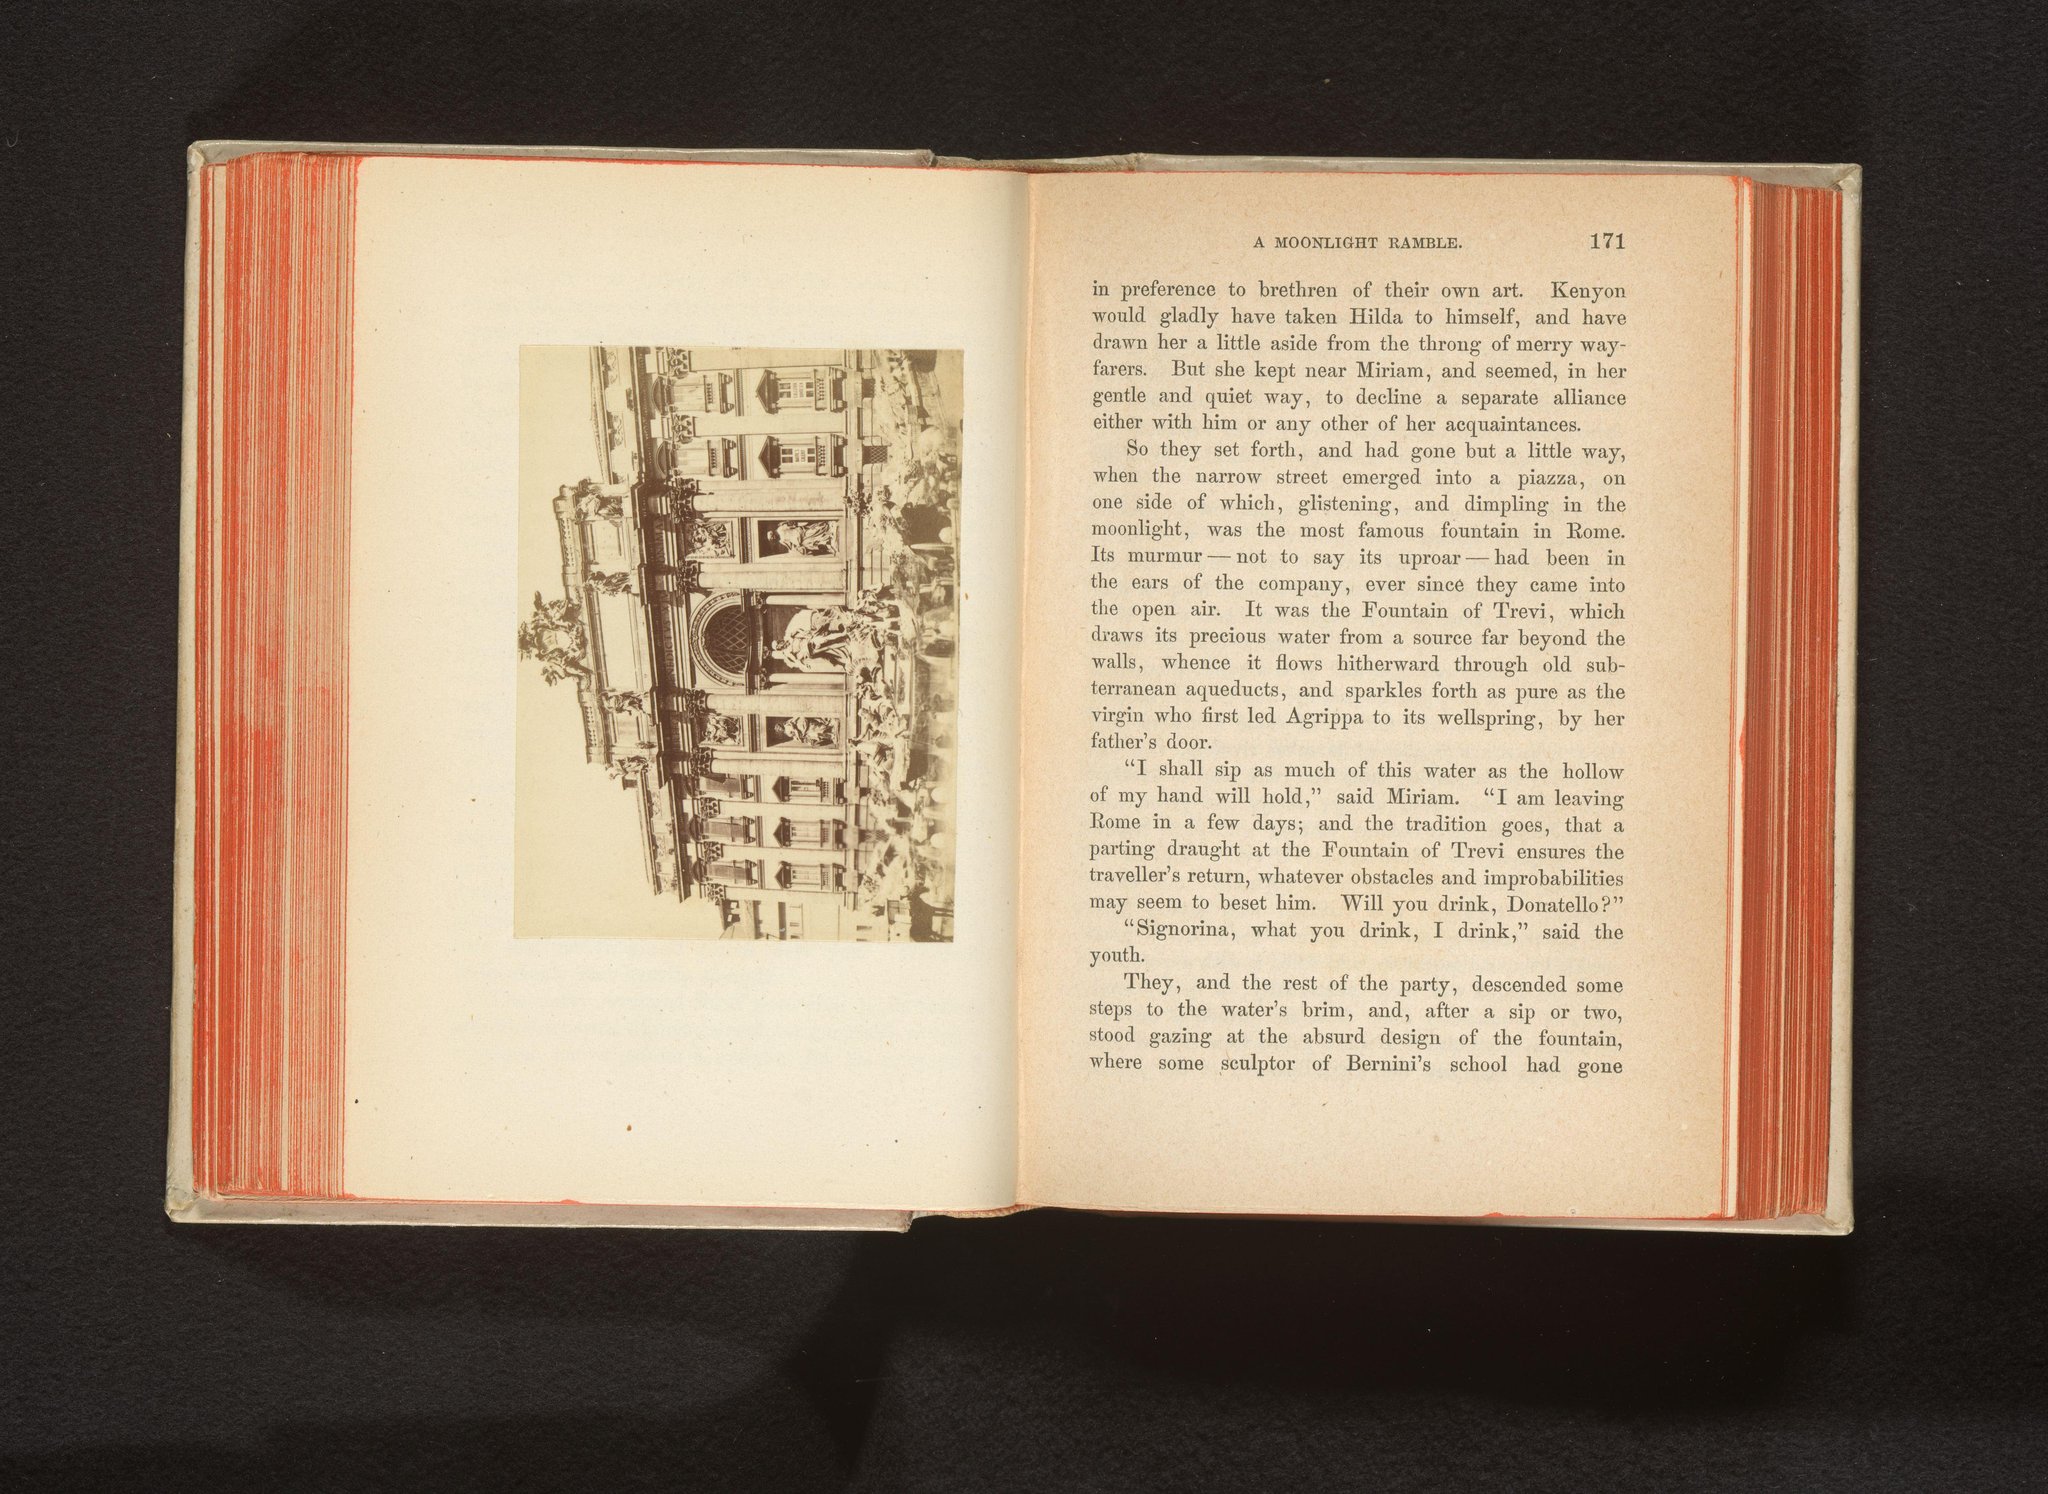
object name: page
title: Gezicht op de Trevifontein in Rome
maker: Anonymous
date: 1850-1860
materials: photographic support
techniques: albumen print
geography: rome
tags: ornamental fountain